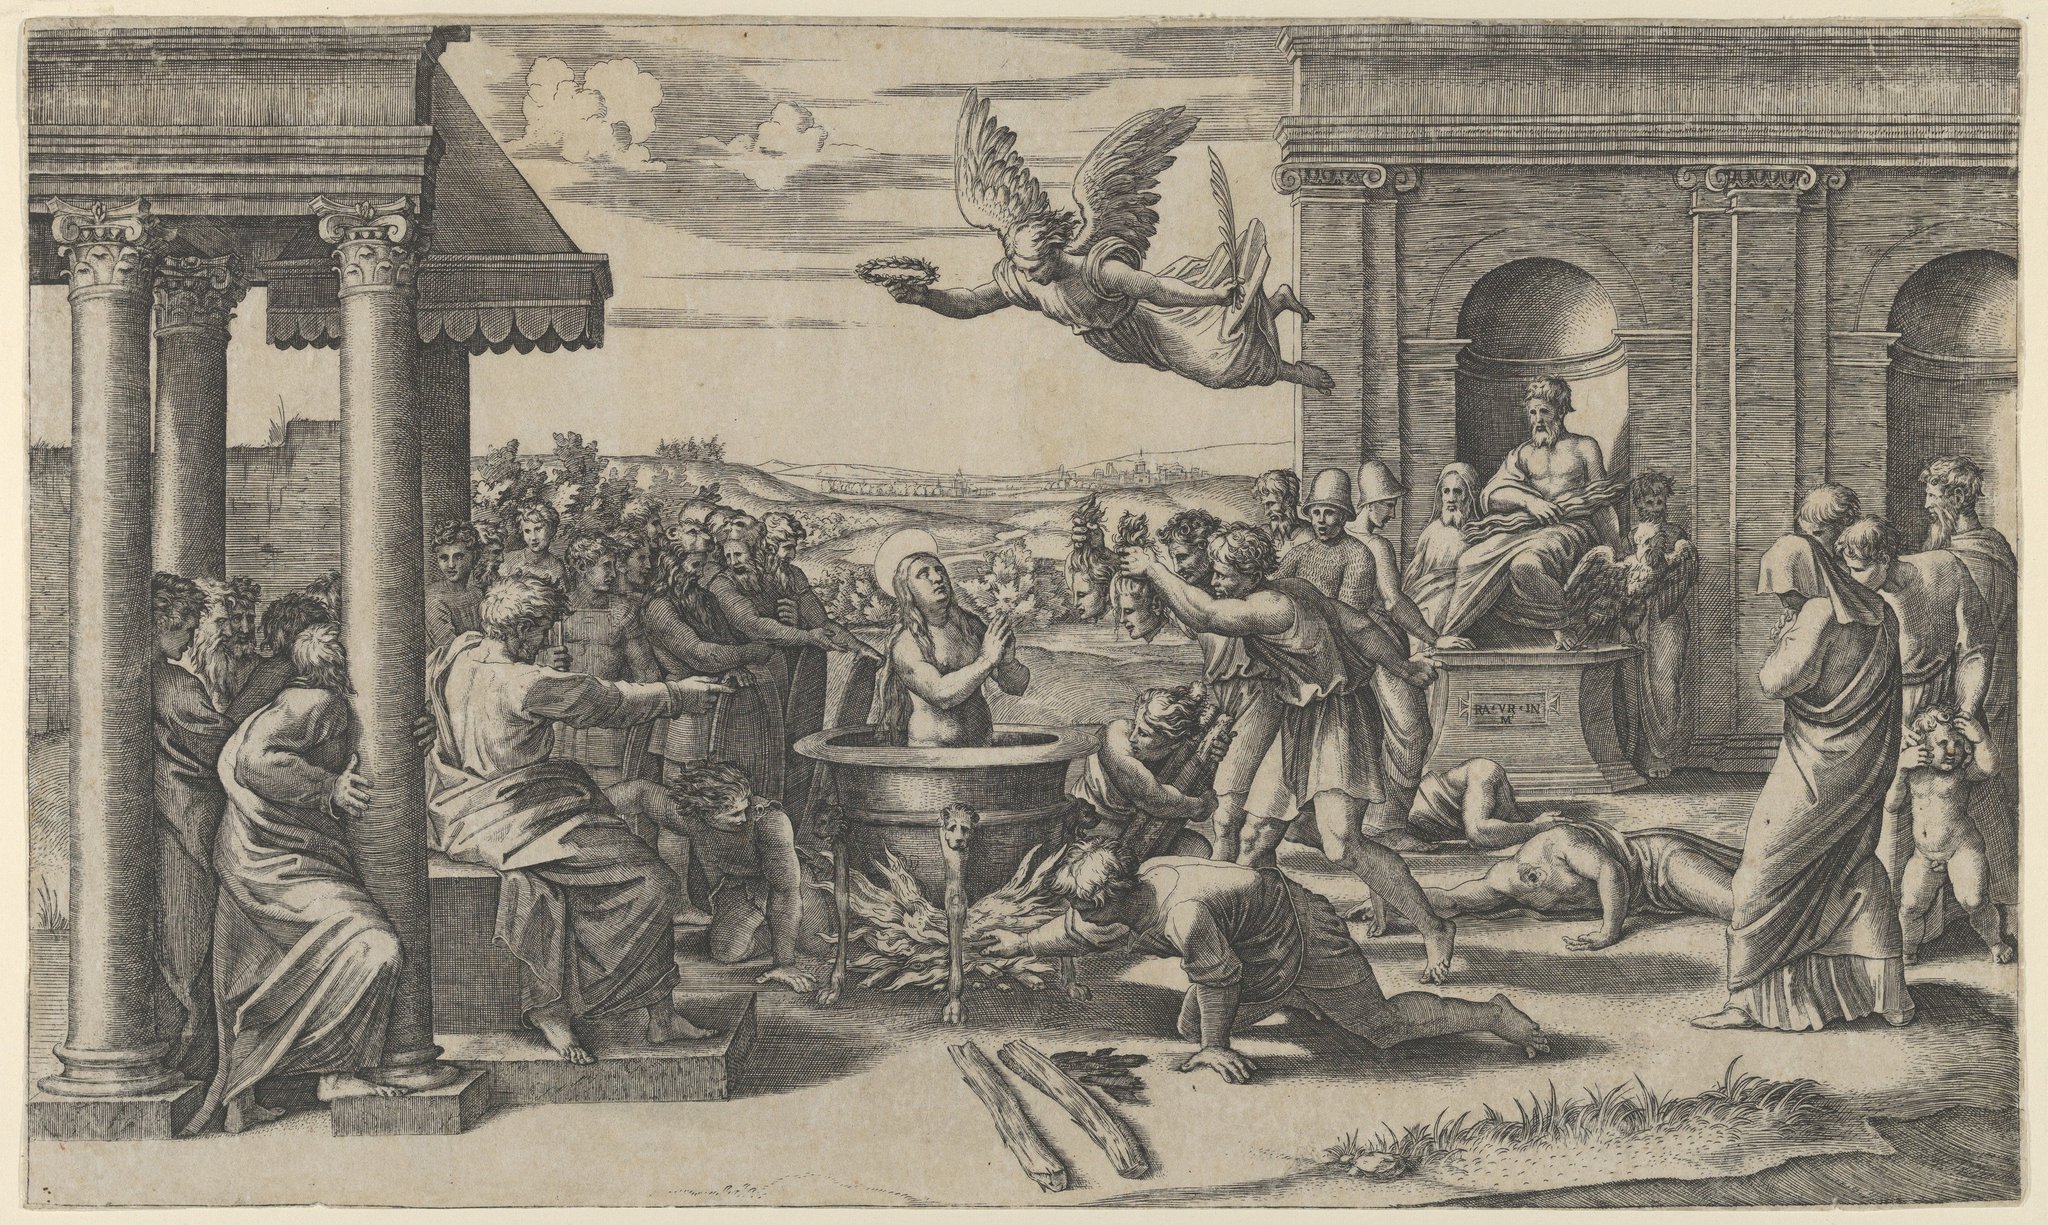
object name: print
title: The Martydom of Saint Cecilia standing naked in a large cauldron, at left under a colonnade, sits a Roman Prefect, at right the statue of Jupiter in a niche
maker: marcantonio raimondi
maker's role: artist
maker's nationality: italian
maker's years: 1475-1534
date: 1520-1525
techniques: engraving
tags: men,jupiter,angels,saints